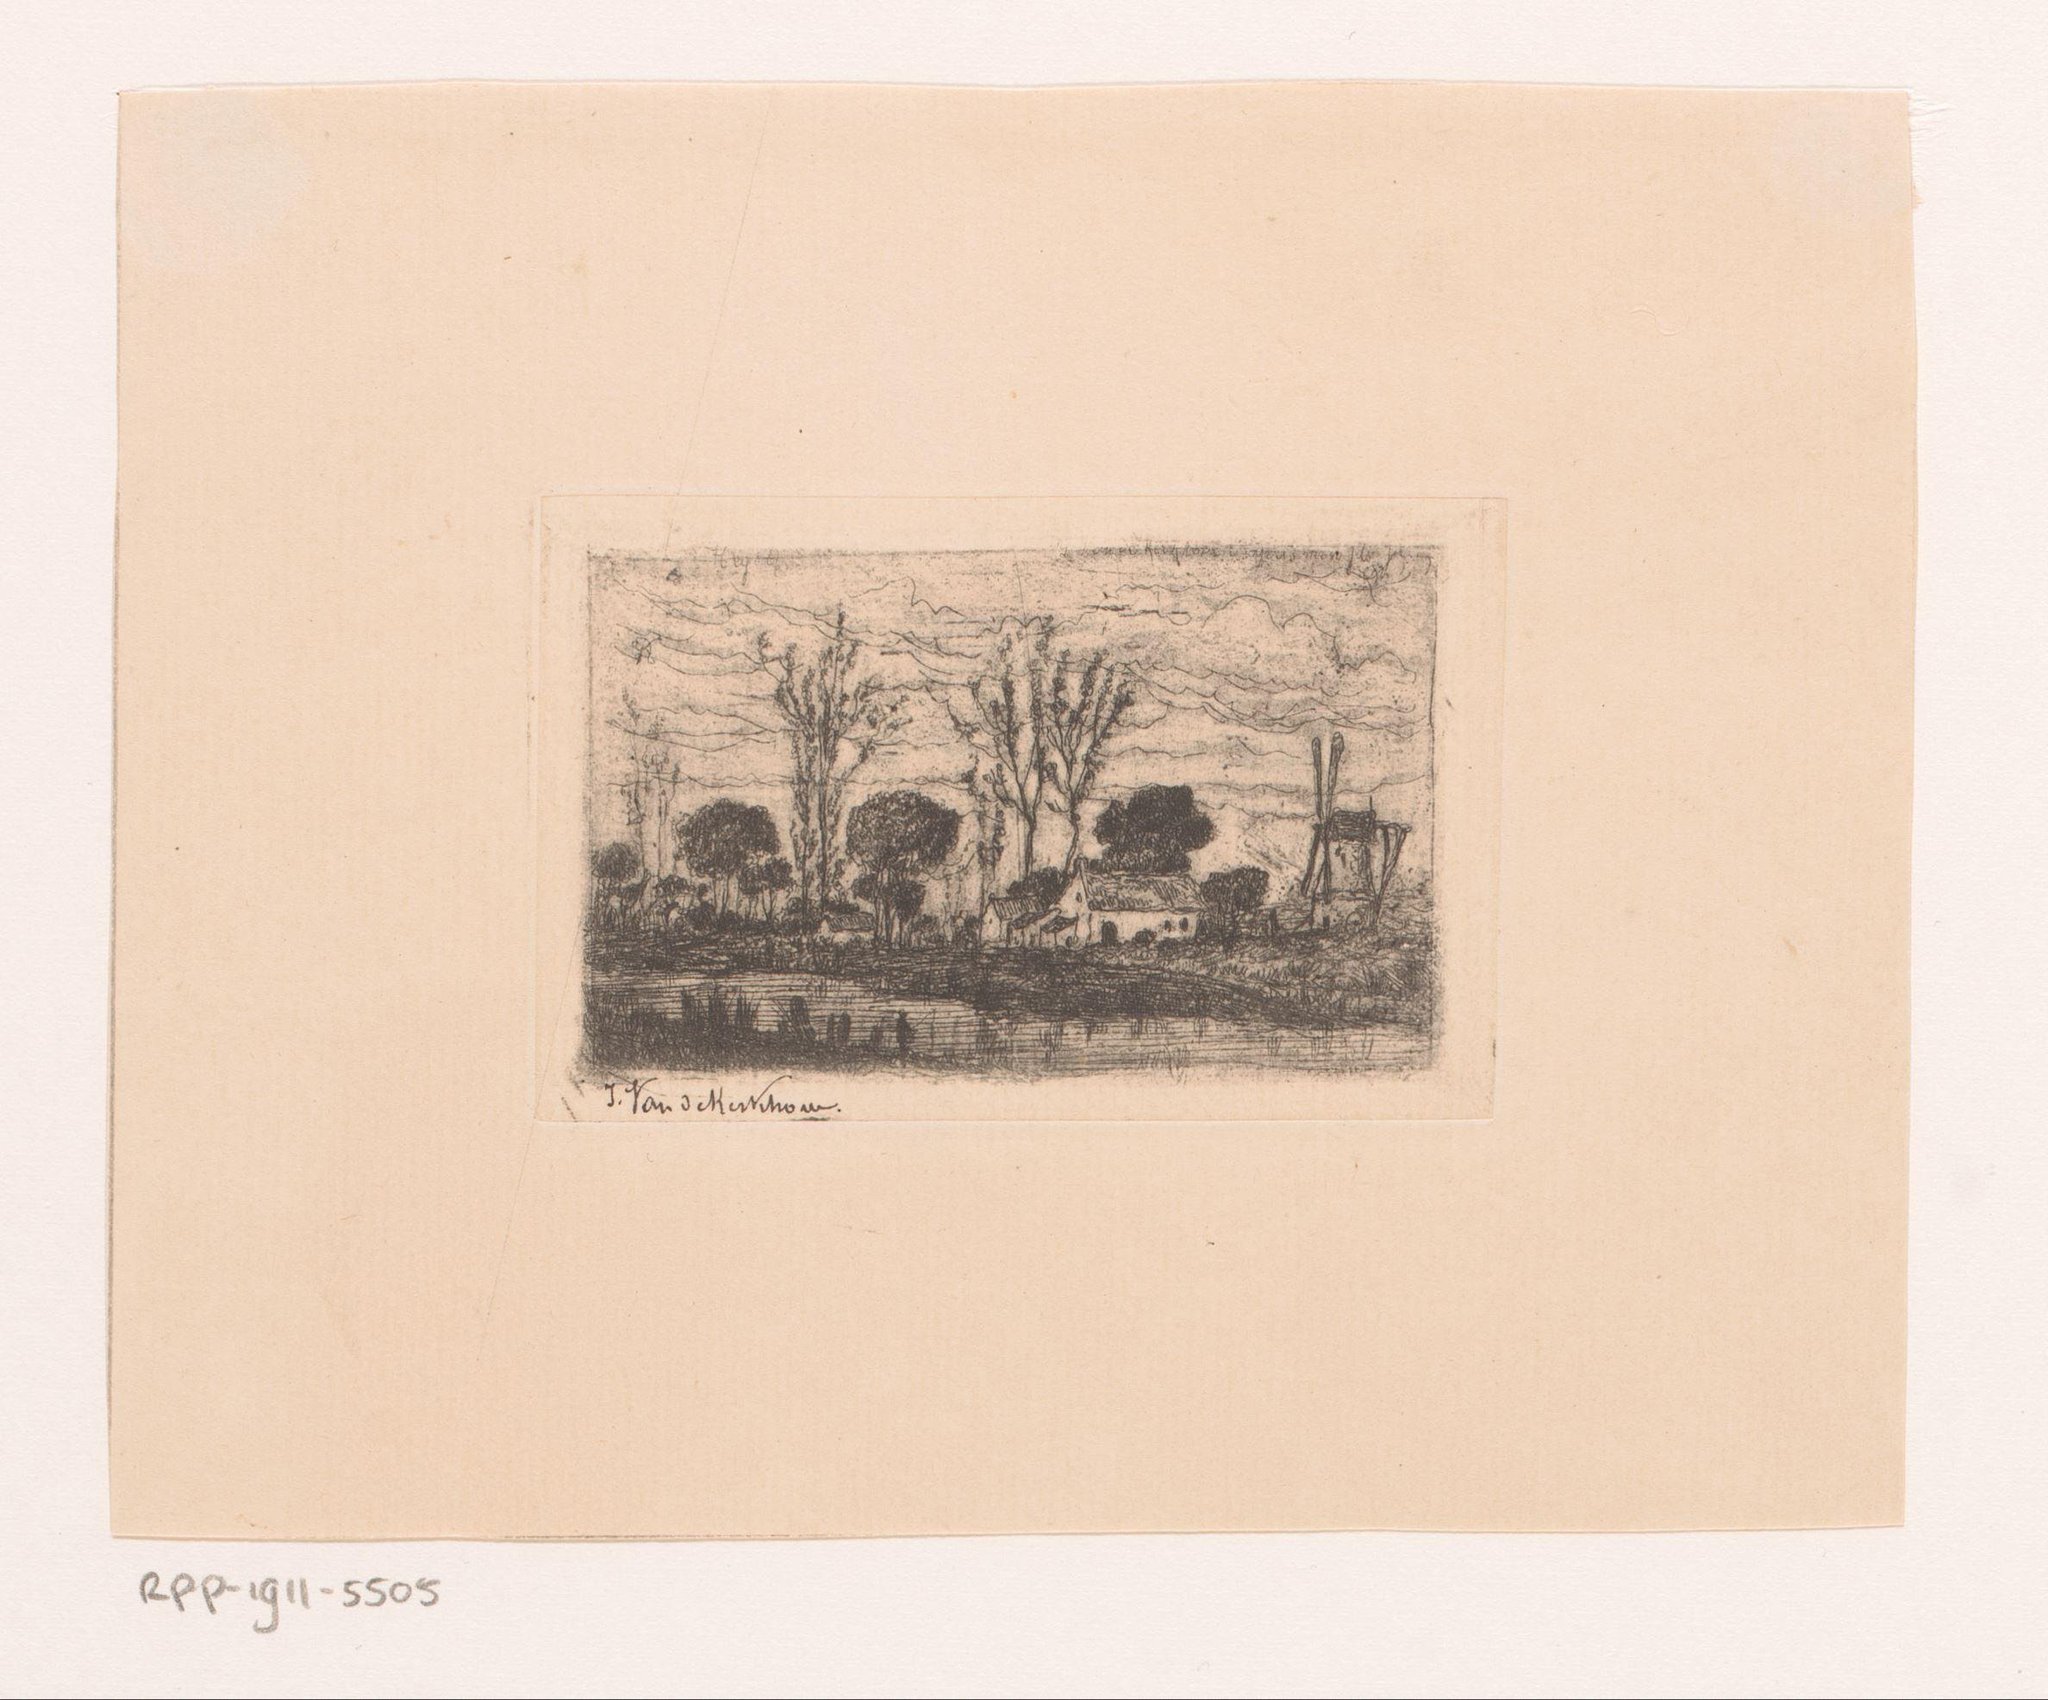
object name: print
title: Boerenwoning en molen in het landschap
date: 1873-1881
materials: paper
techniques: etching, intaglio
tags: windmill in landscape, farm or solitary house in landscape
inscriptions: collector's mark: Lugt 2228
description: De etsen naar de schilderijen van Frédéric Van de Kerkhove werden na zijn dood door zijn vader en zuster gemaakt en uitgegeven in twee reeksen. De eerste werd in 1877 uitgegeven door het Journal des Beaux-Arts et de la Littérature: Cahier de 25 Eaux-fortes d'après Frédéric van de Kerkhove, gravées par son père et sa sœur. De tweede reeks van 126 etsen, ook in 1877, werd in Parijs uitgegeven bij A. Lévy onder de titel Cent eaux-fortes gravées par J. Van de Kerkhove d'après les tableaux de Frédéric Van de Kerkhove, mort en 1873 à l'âge de 10 ans et 11 mois.